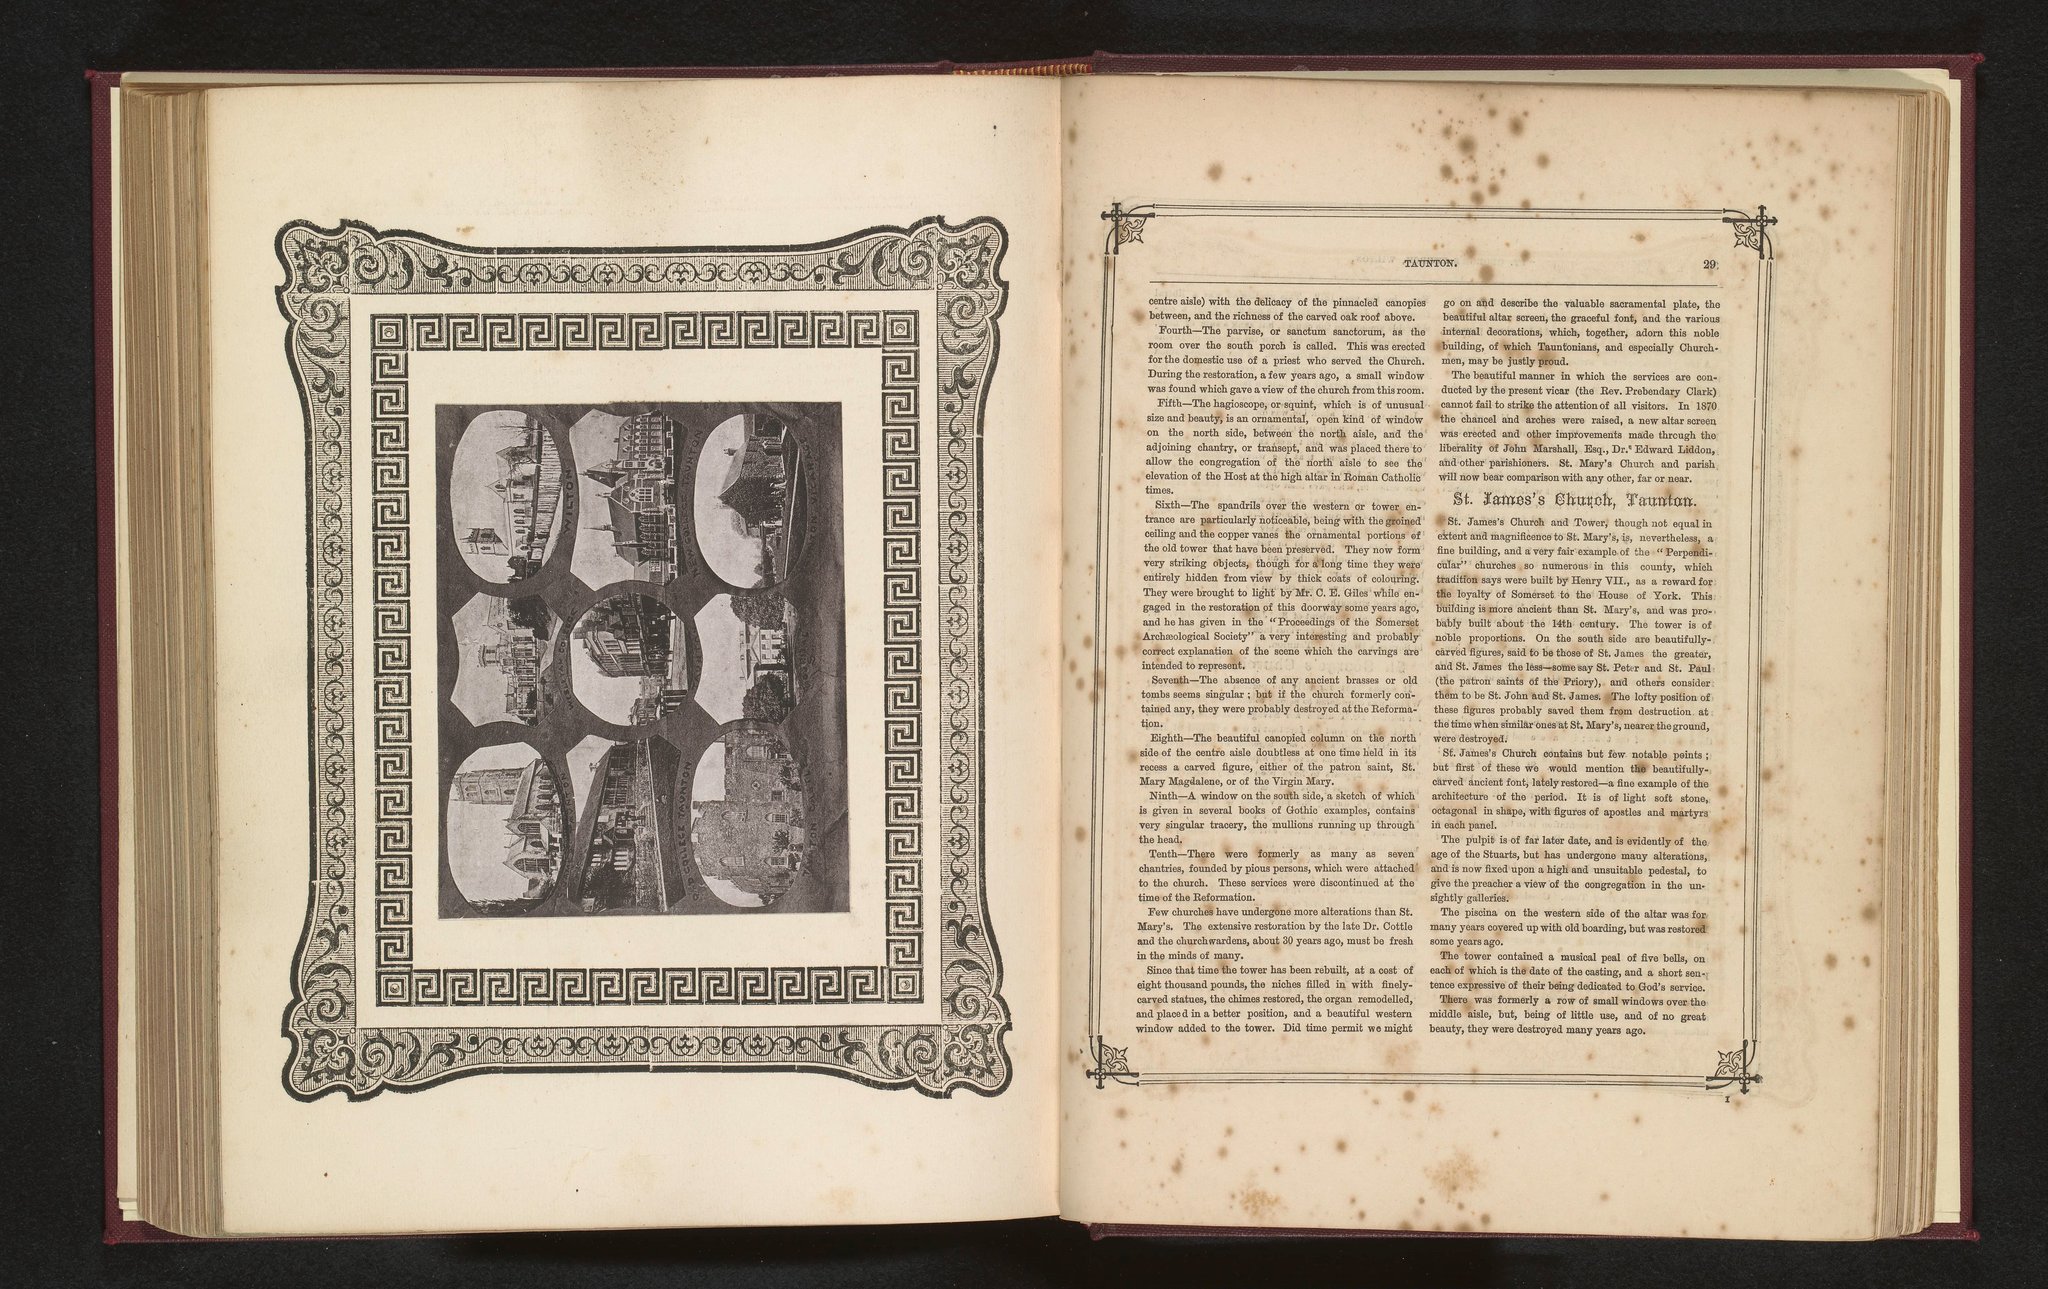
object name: photomechanical print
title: Negen gezichten op gebouwen in West Dorset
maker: Anonymous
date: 1868-1873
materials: paper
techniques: photoaquatint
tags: church (exterior), exterior ~ representation of a building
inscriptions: inscription: ‘S James Taunton (...) Taunton Vicarace’